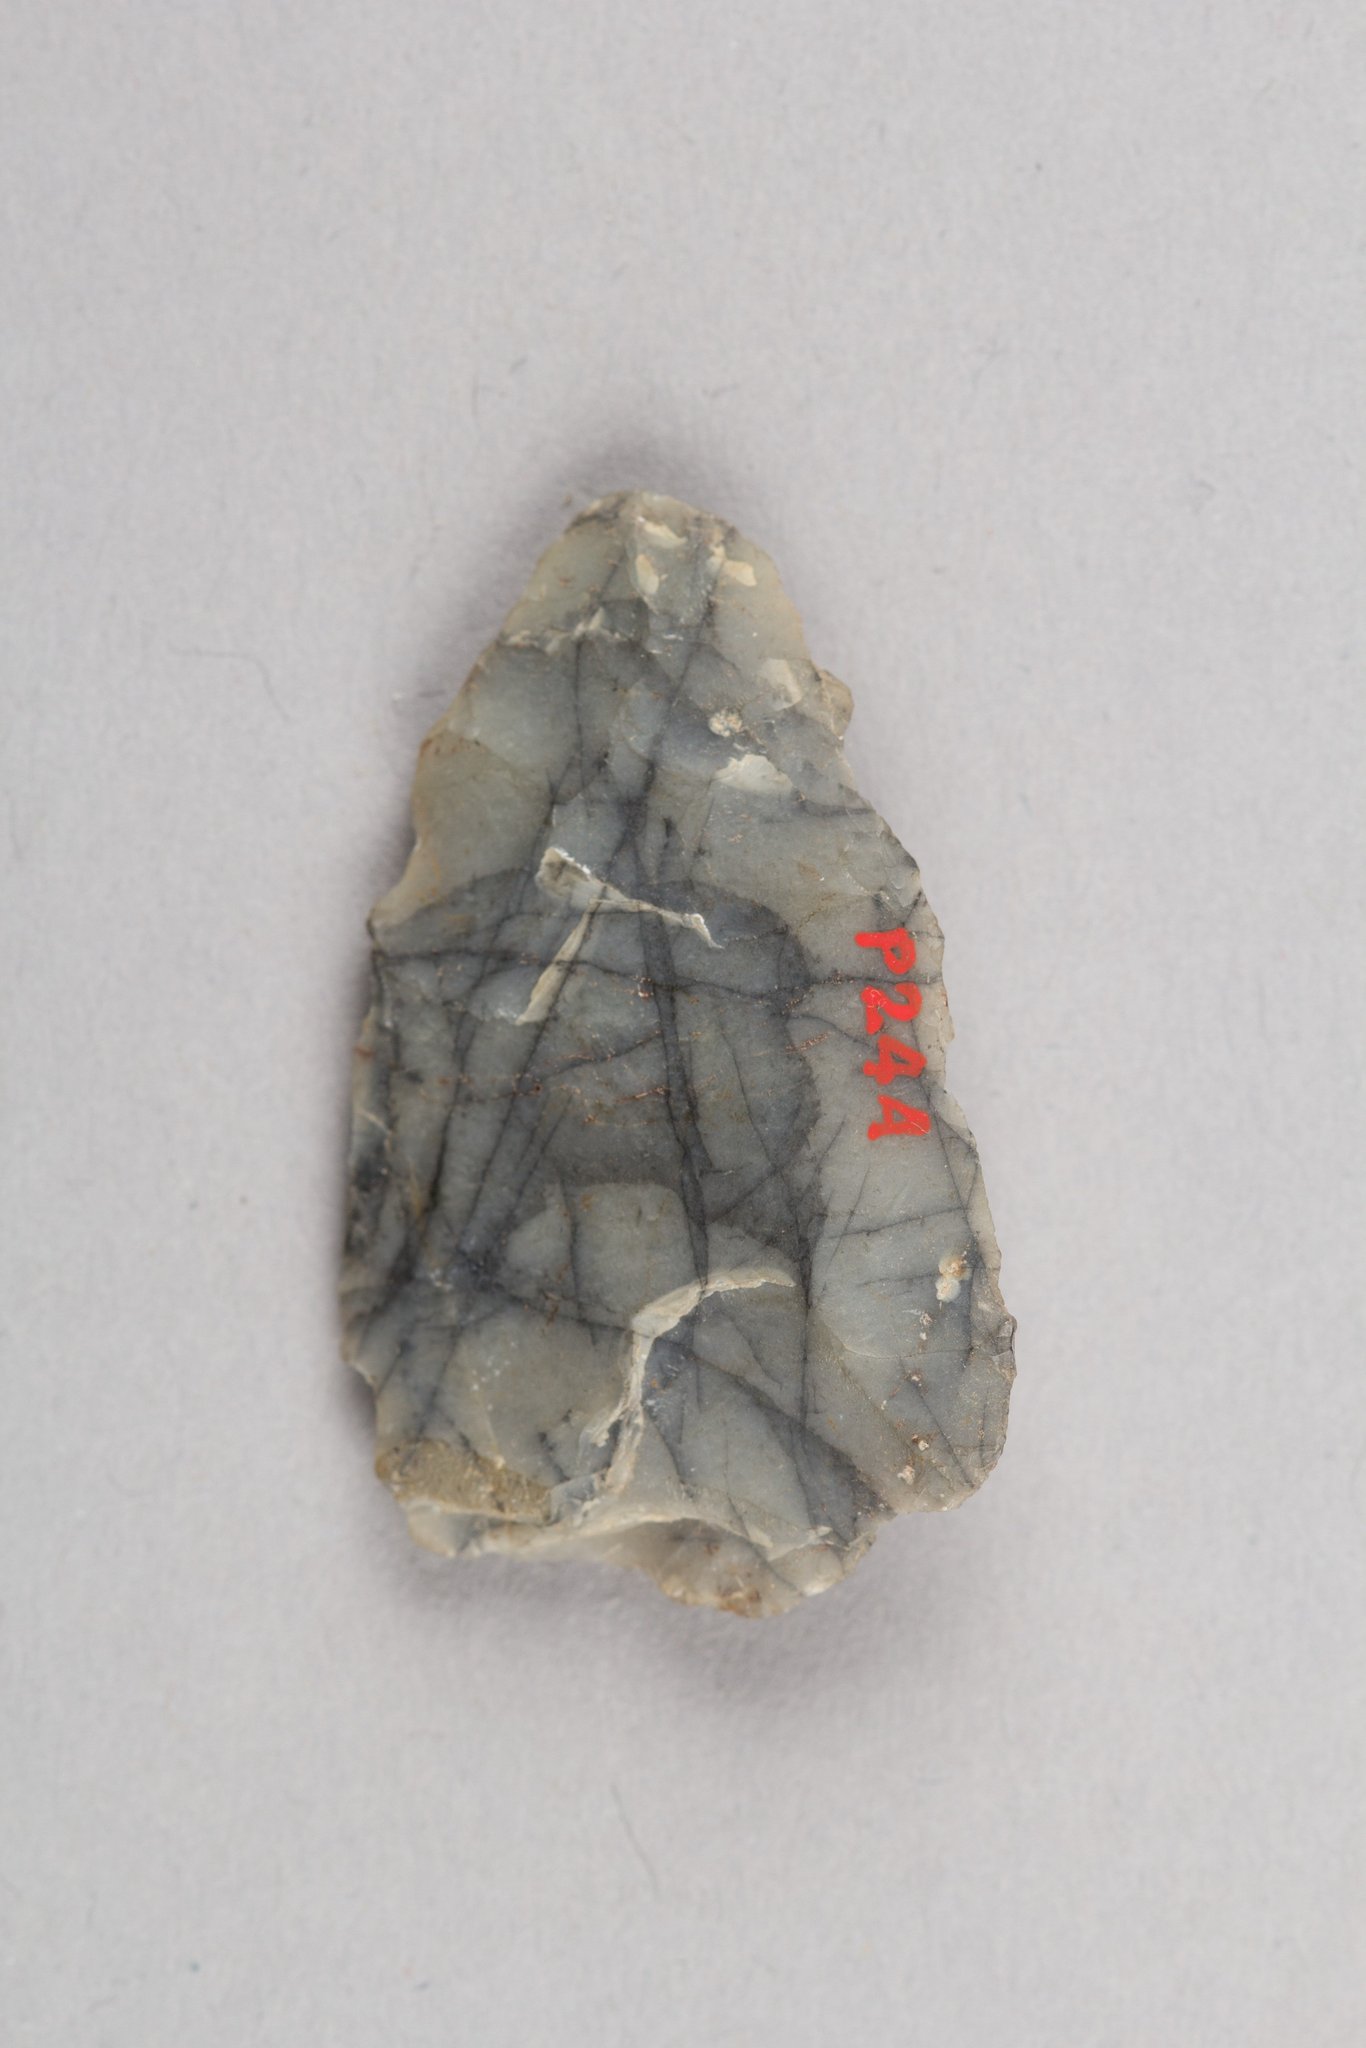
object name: arrowhead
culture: japanese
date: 1500-1000 BCE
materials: stone